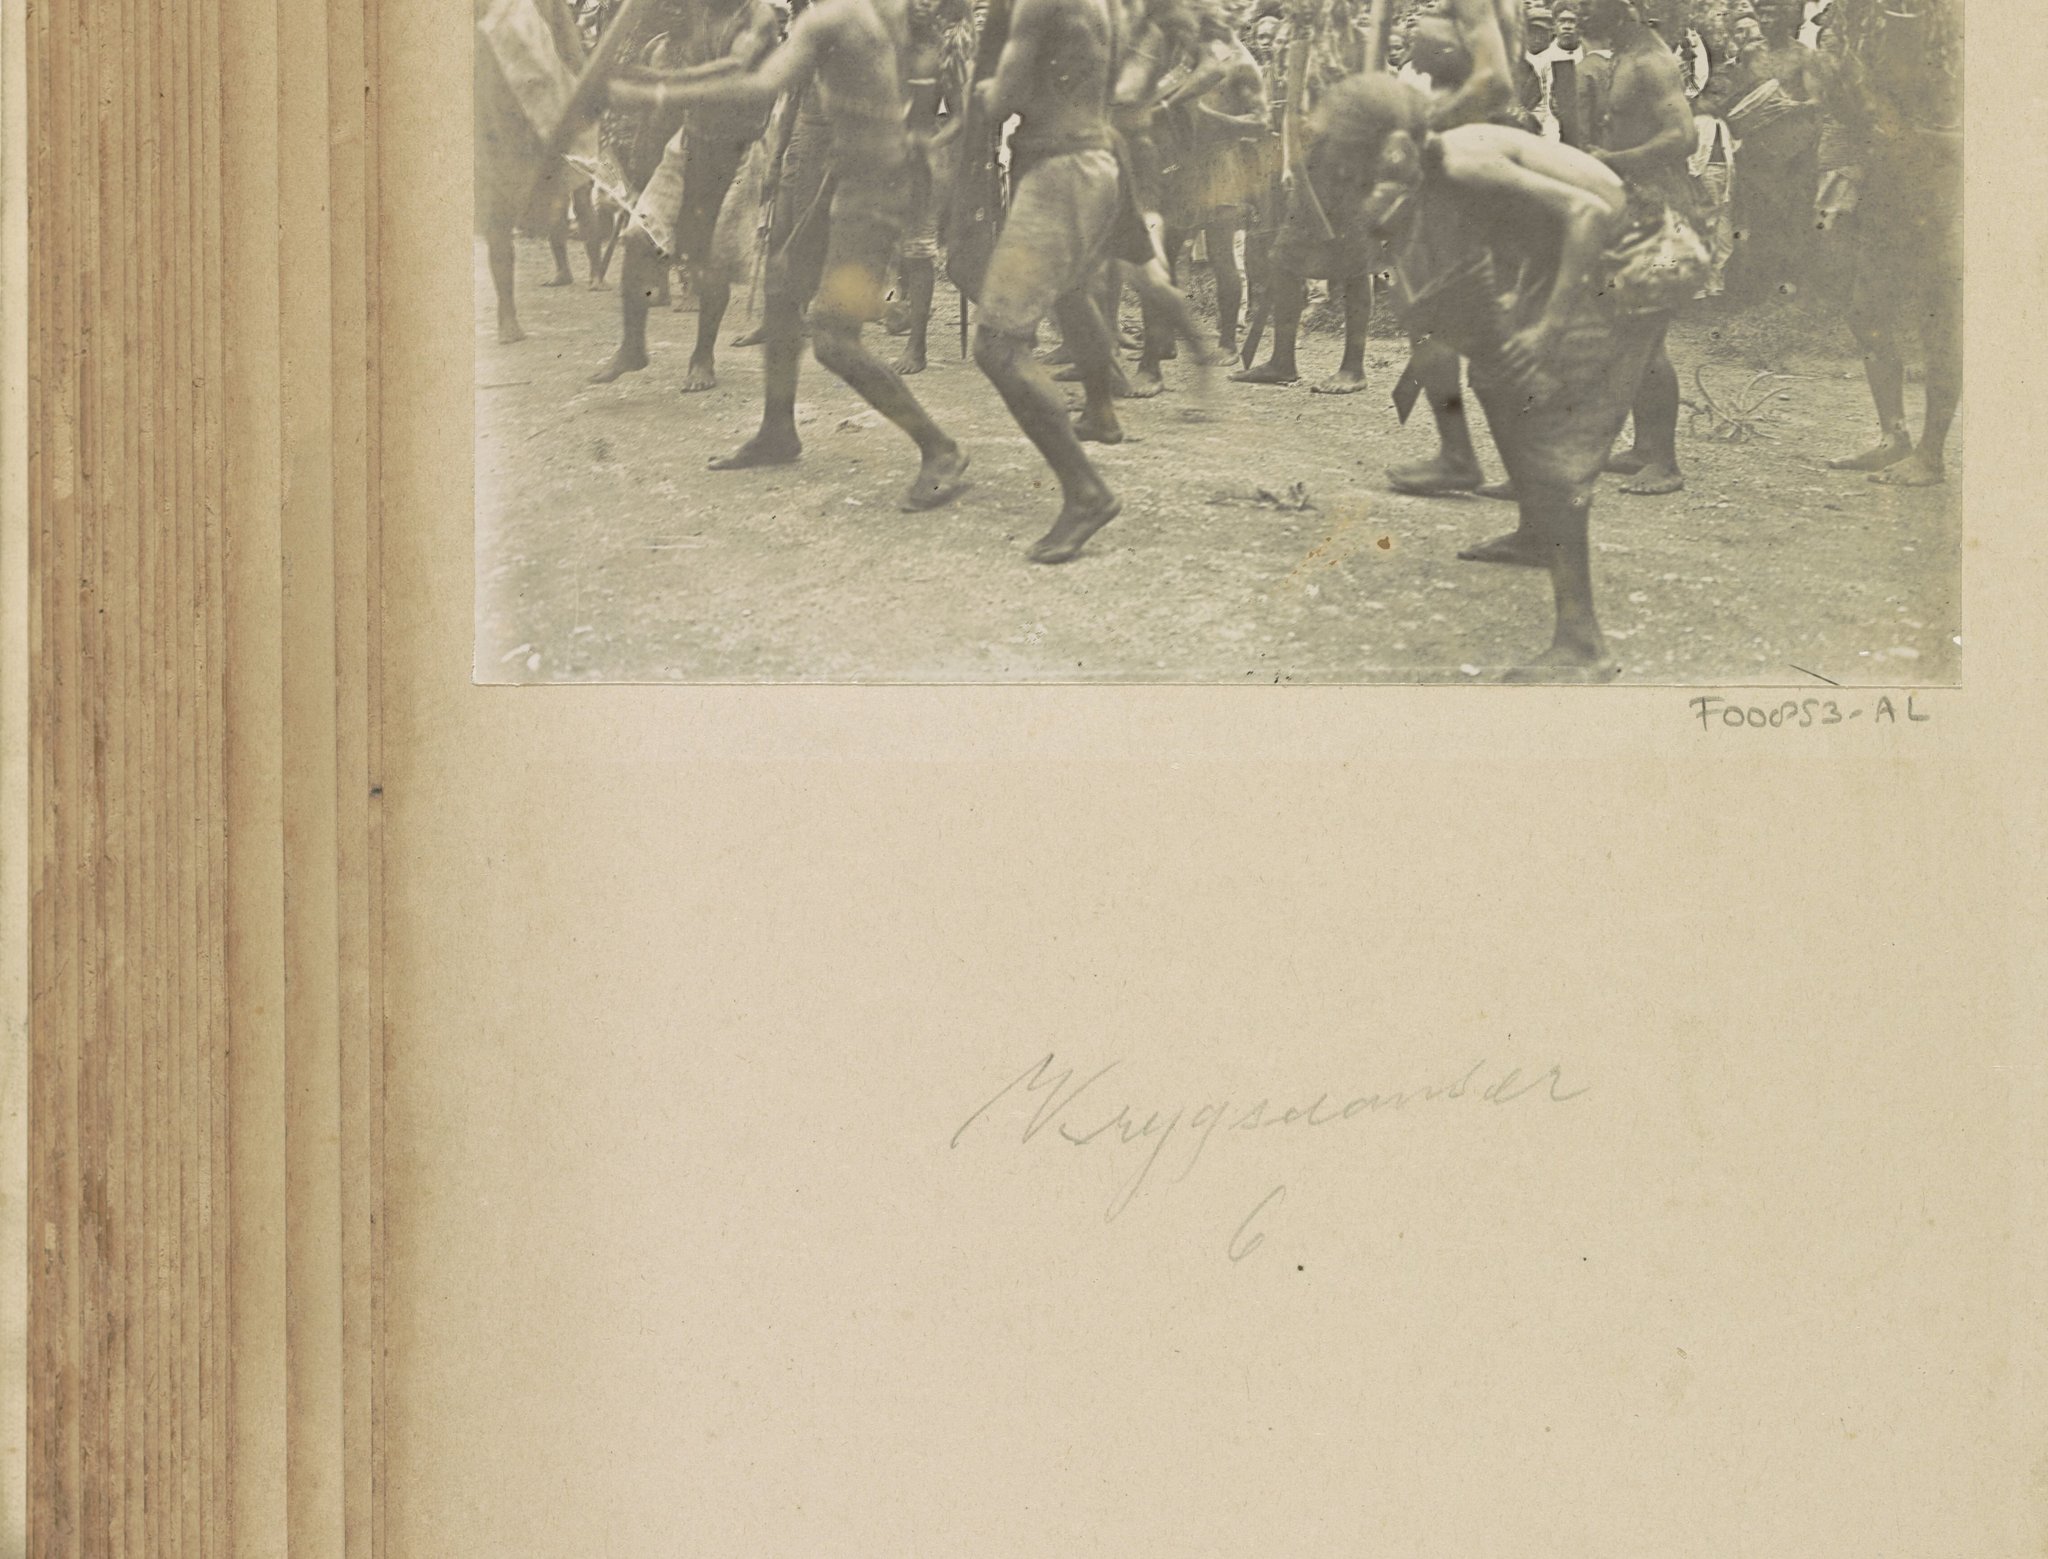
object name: photograph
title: Mannen voeren krijgsdans uit op Ambon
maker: Anonymous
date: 1900-1920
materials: cardboard, paper, photographic support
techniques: gelatin silver print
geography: ambon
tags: group dancing, dutch east indies, the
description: Onderdeel van Reisalbum met foto's van Ambon.